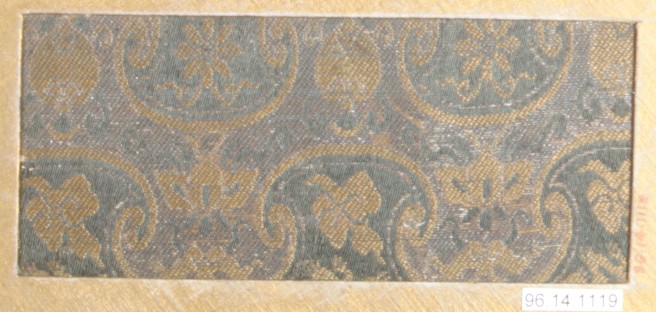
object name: piece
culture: japanese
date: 1701-1900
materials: silk